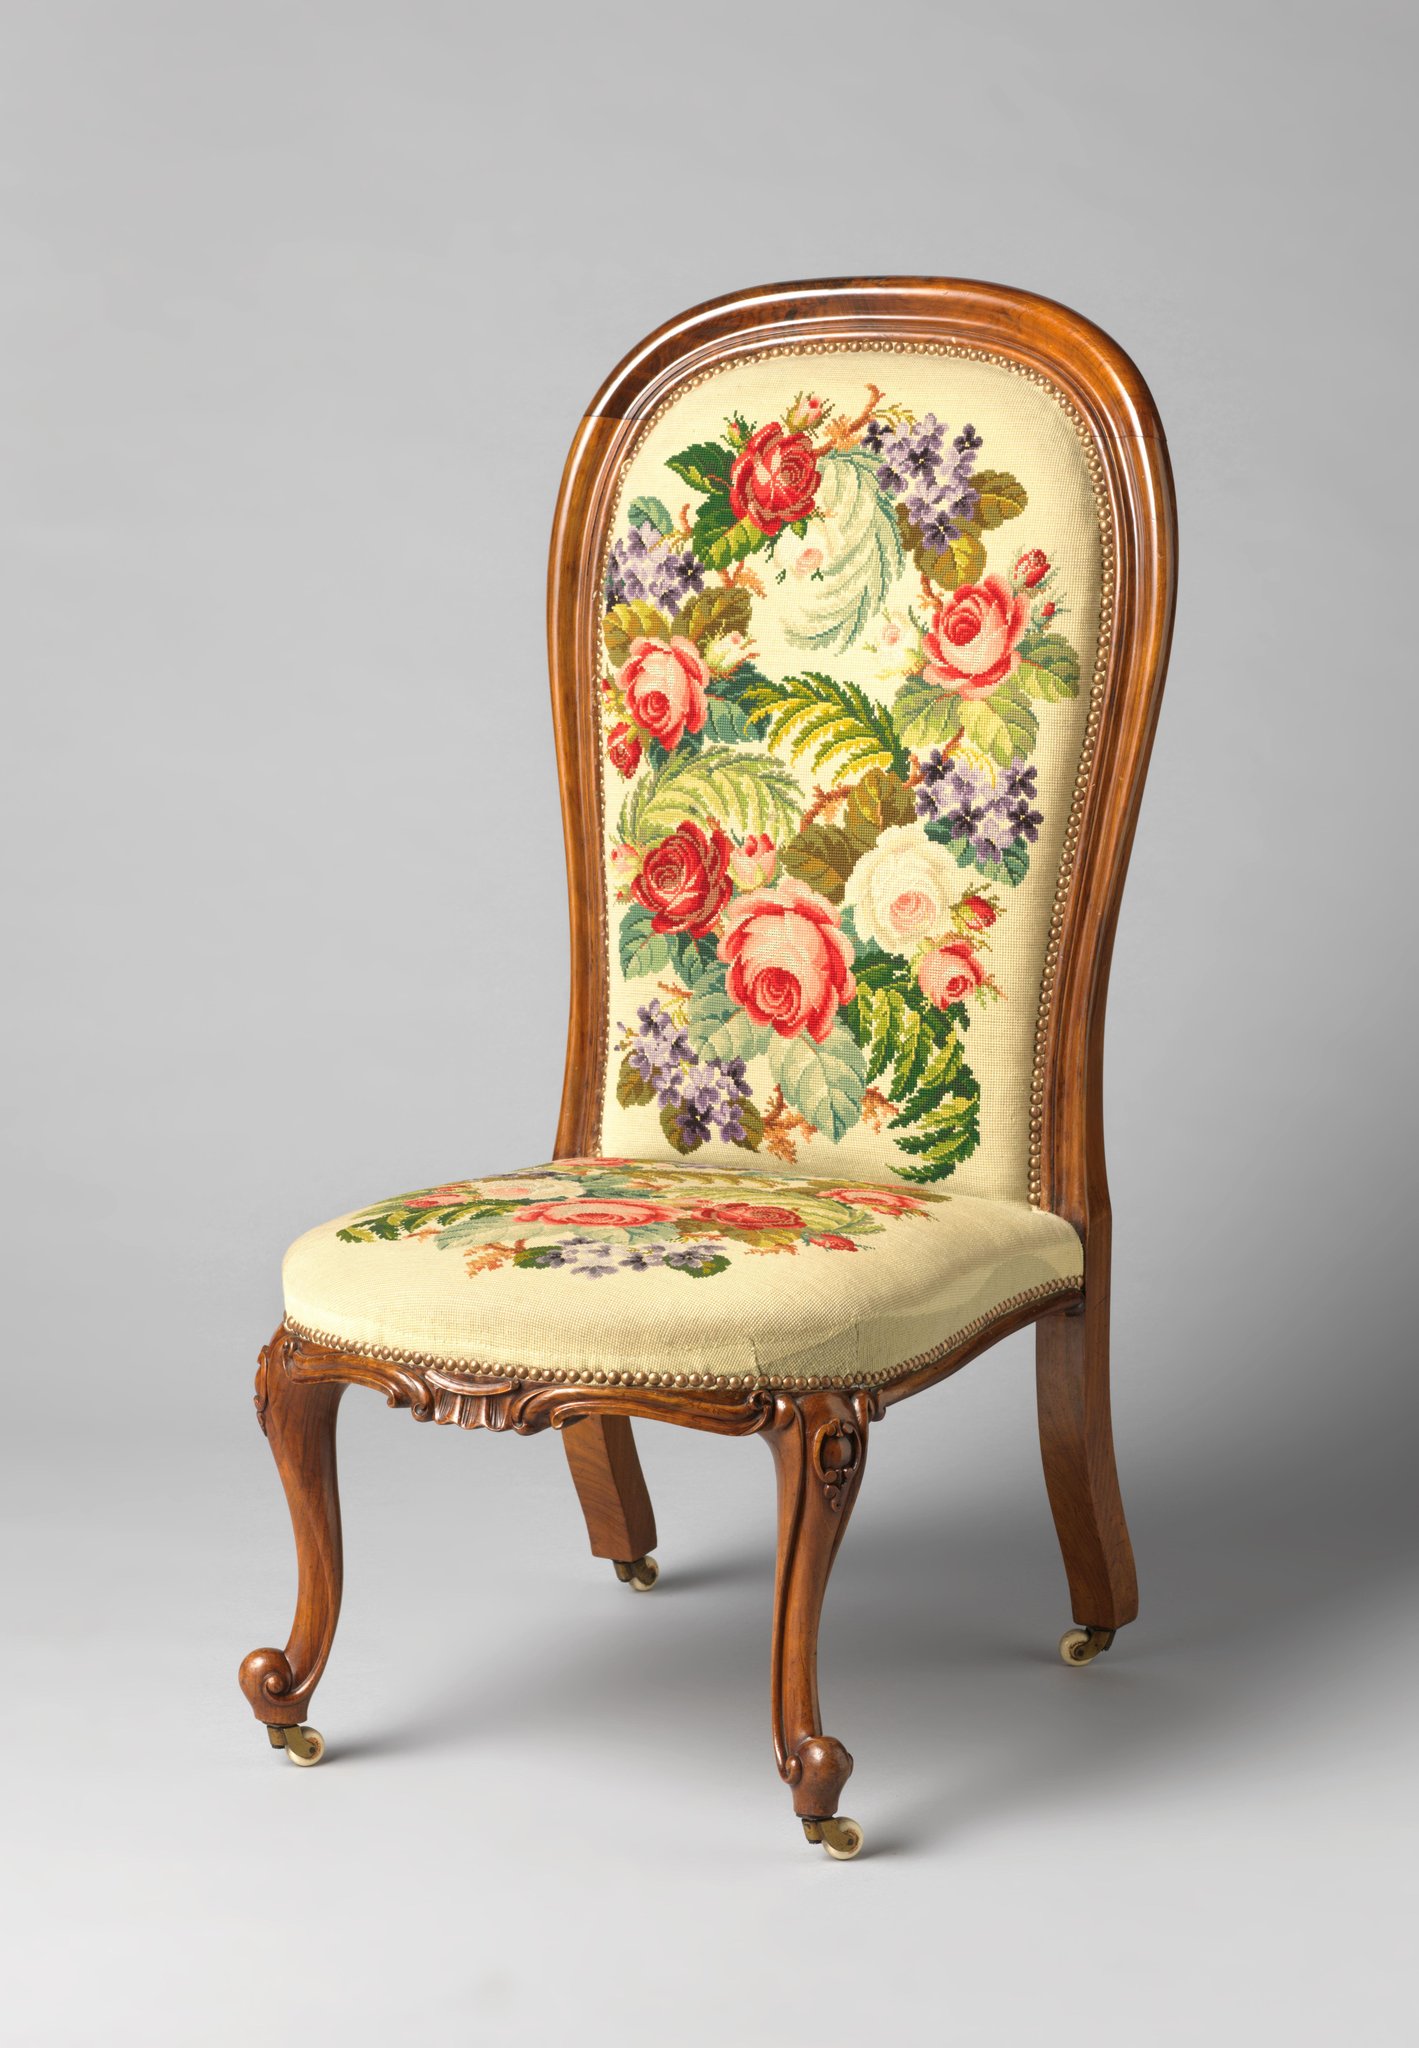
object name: stoelbekleding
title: Stoelbekleding van Berlijns borduurwerk, bestaande uit een stoelrug en een stoelzitting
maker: Anonymous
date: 1830-1840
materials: silk, wool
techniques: embroidery, cross stitching, embroidered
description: Stoelbekleding van Berlijns borduurwerk in kruissteek, bestaande uit een stoelrug en een stoelzitting. Op een groen fond vertoont een ovale rozenkrans, waartussen maartse viooltjes en varenbladeren.